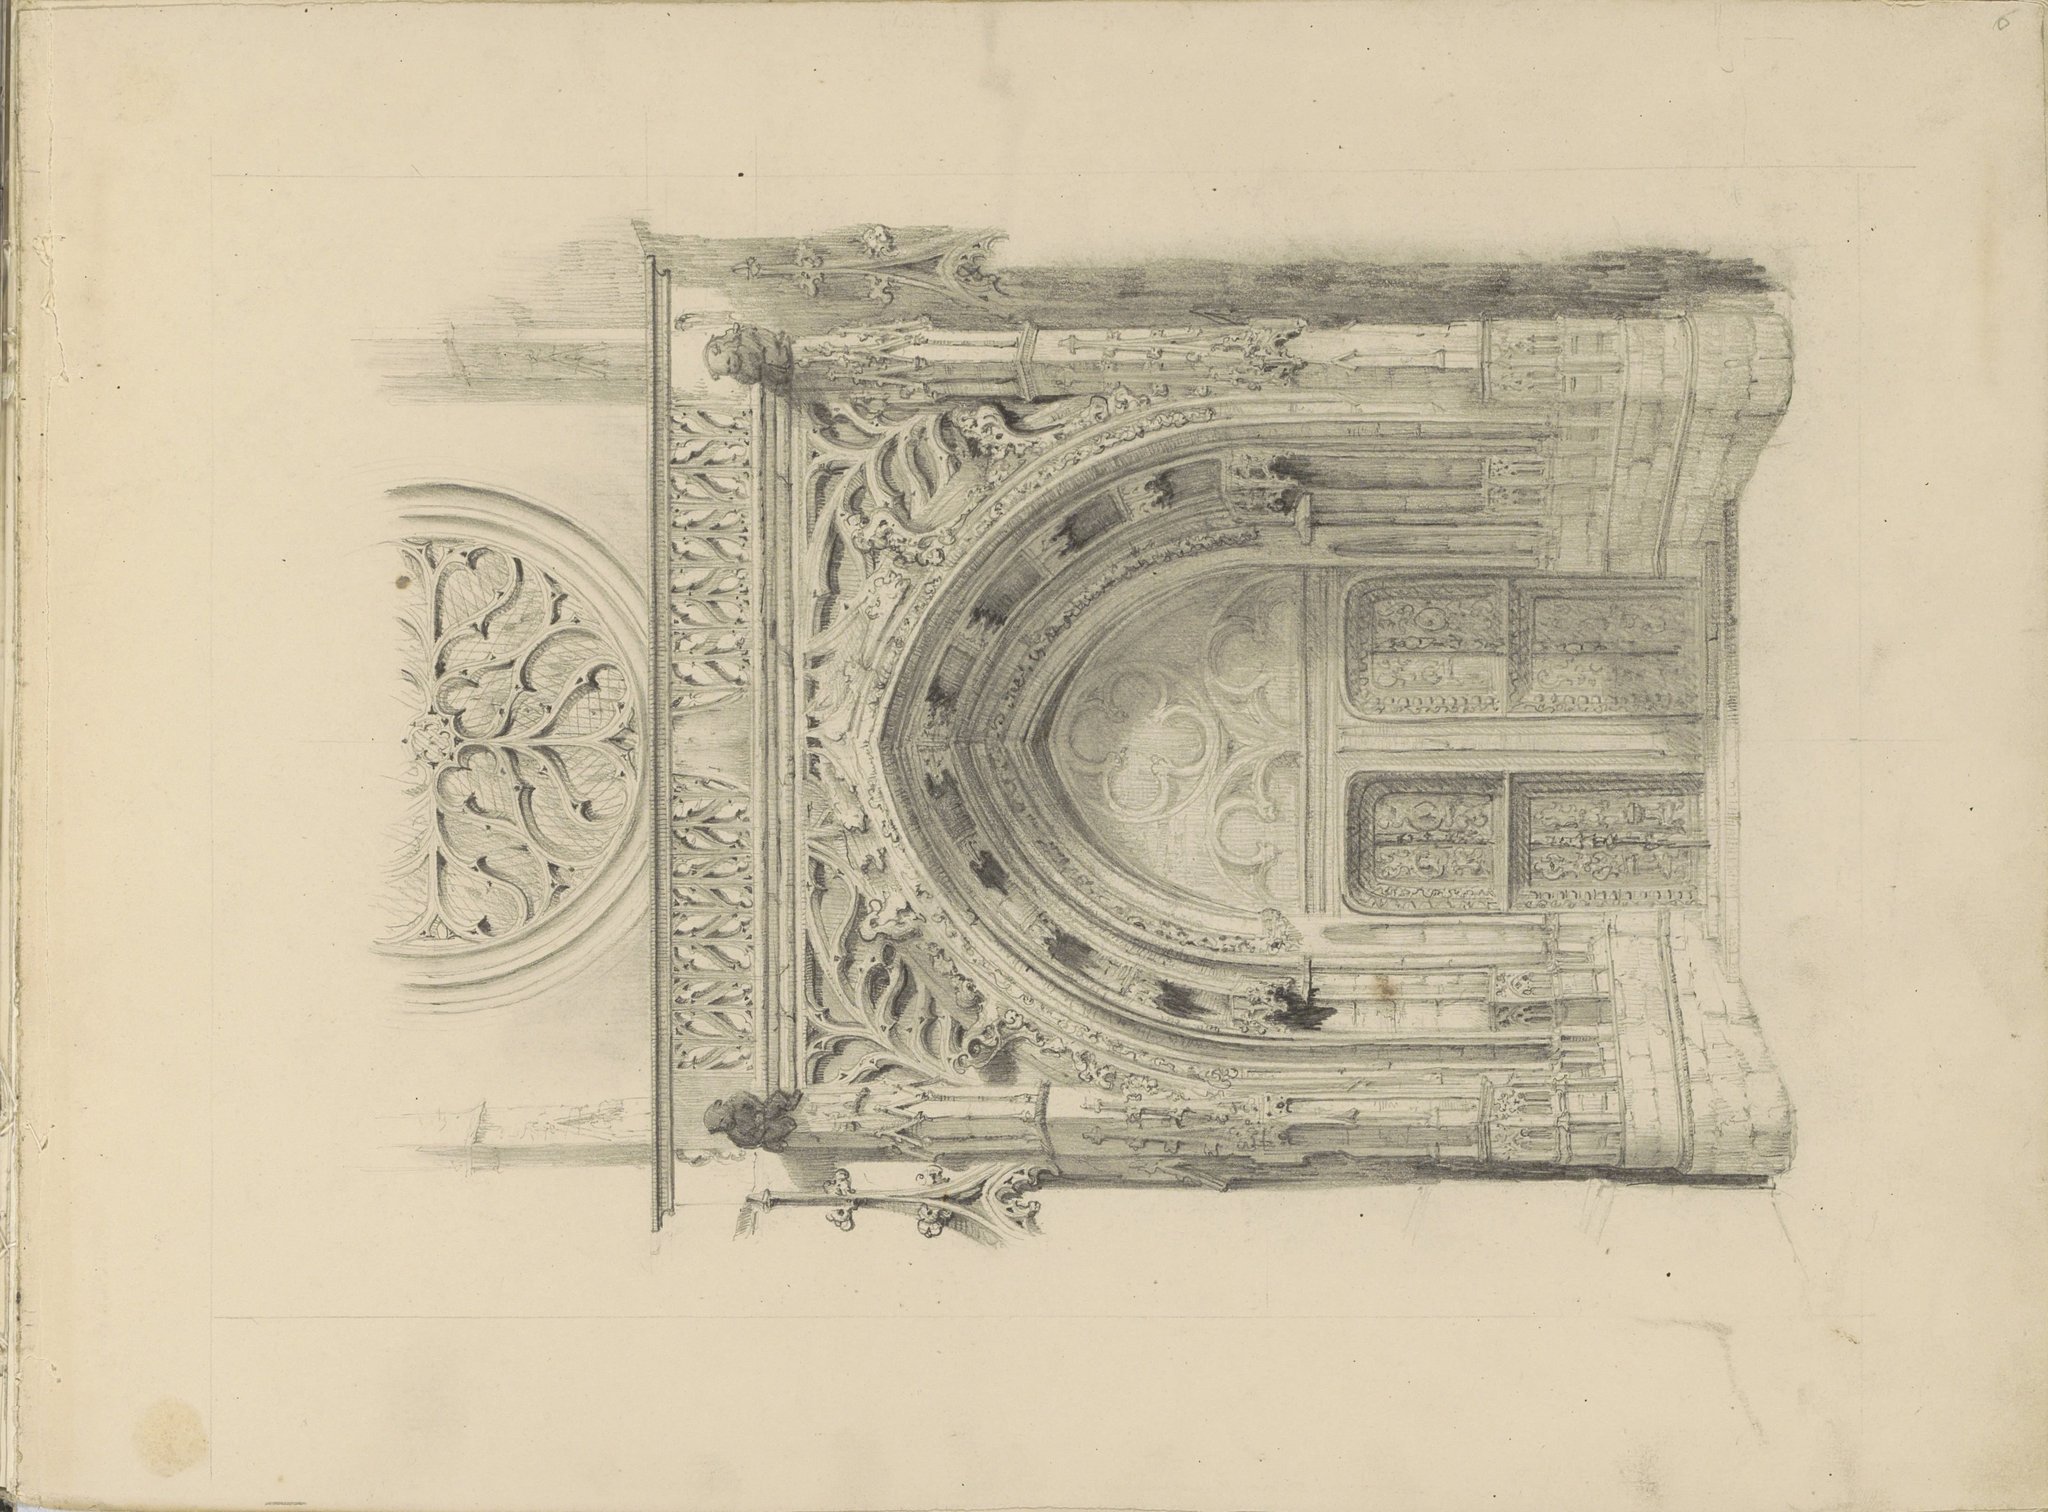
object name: sketchbook leaf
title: Portaal van een kathedraal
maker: pierre joseph hubert cuypers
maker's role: draughtsman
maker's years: 1827-1921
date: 1850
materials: paper, pencil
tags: parts of church exterior and annexes: portal, church-window, e.g. rose-window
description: Portaal met vierpasmotief. Boven het portaal een roosvenster. Blad 6 recto uit een schetsboek met 37 bladen.